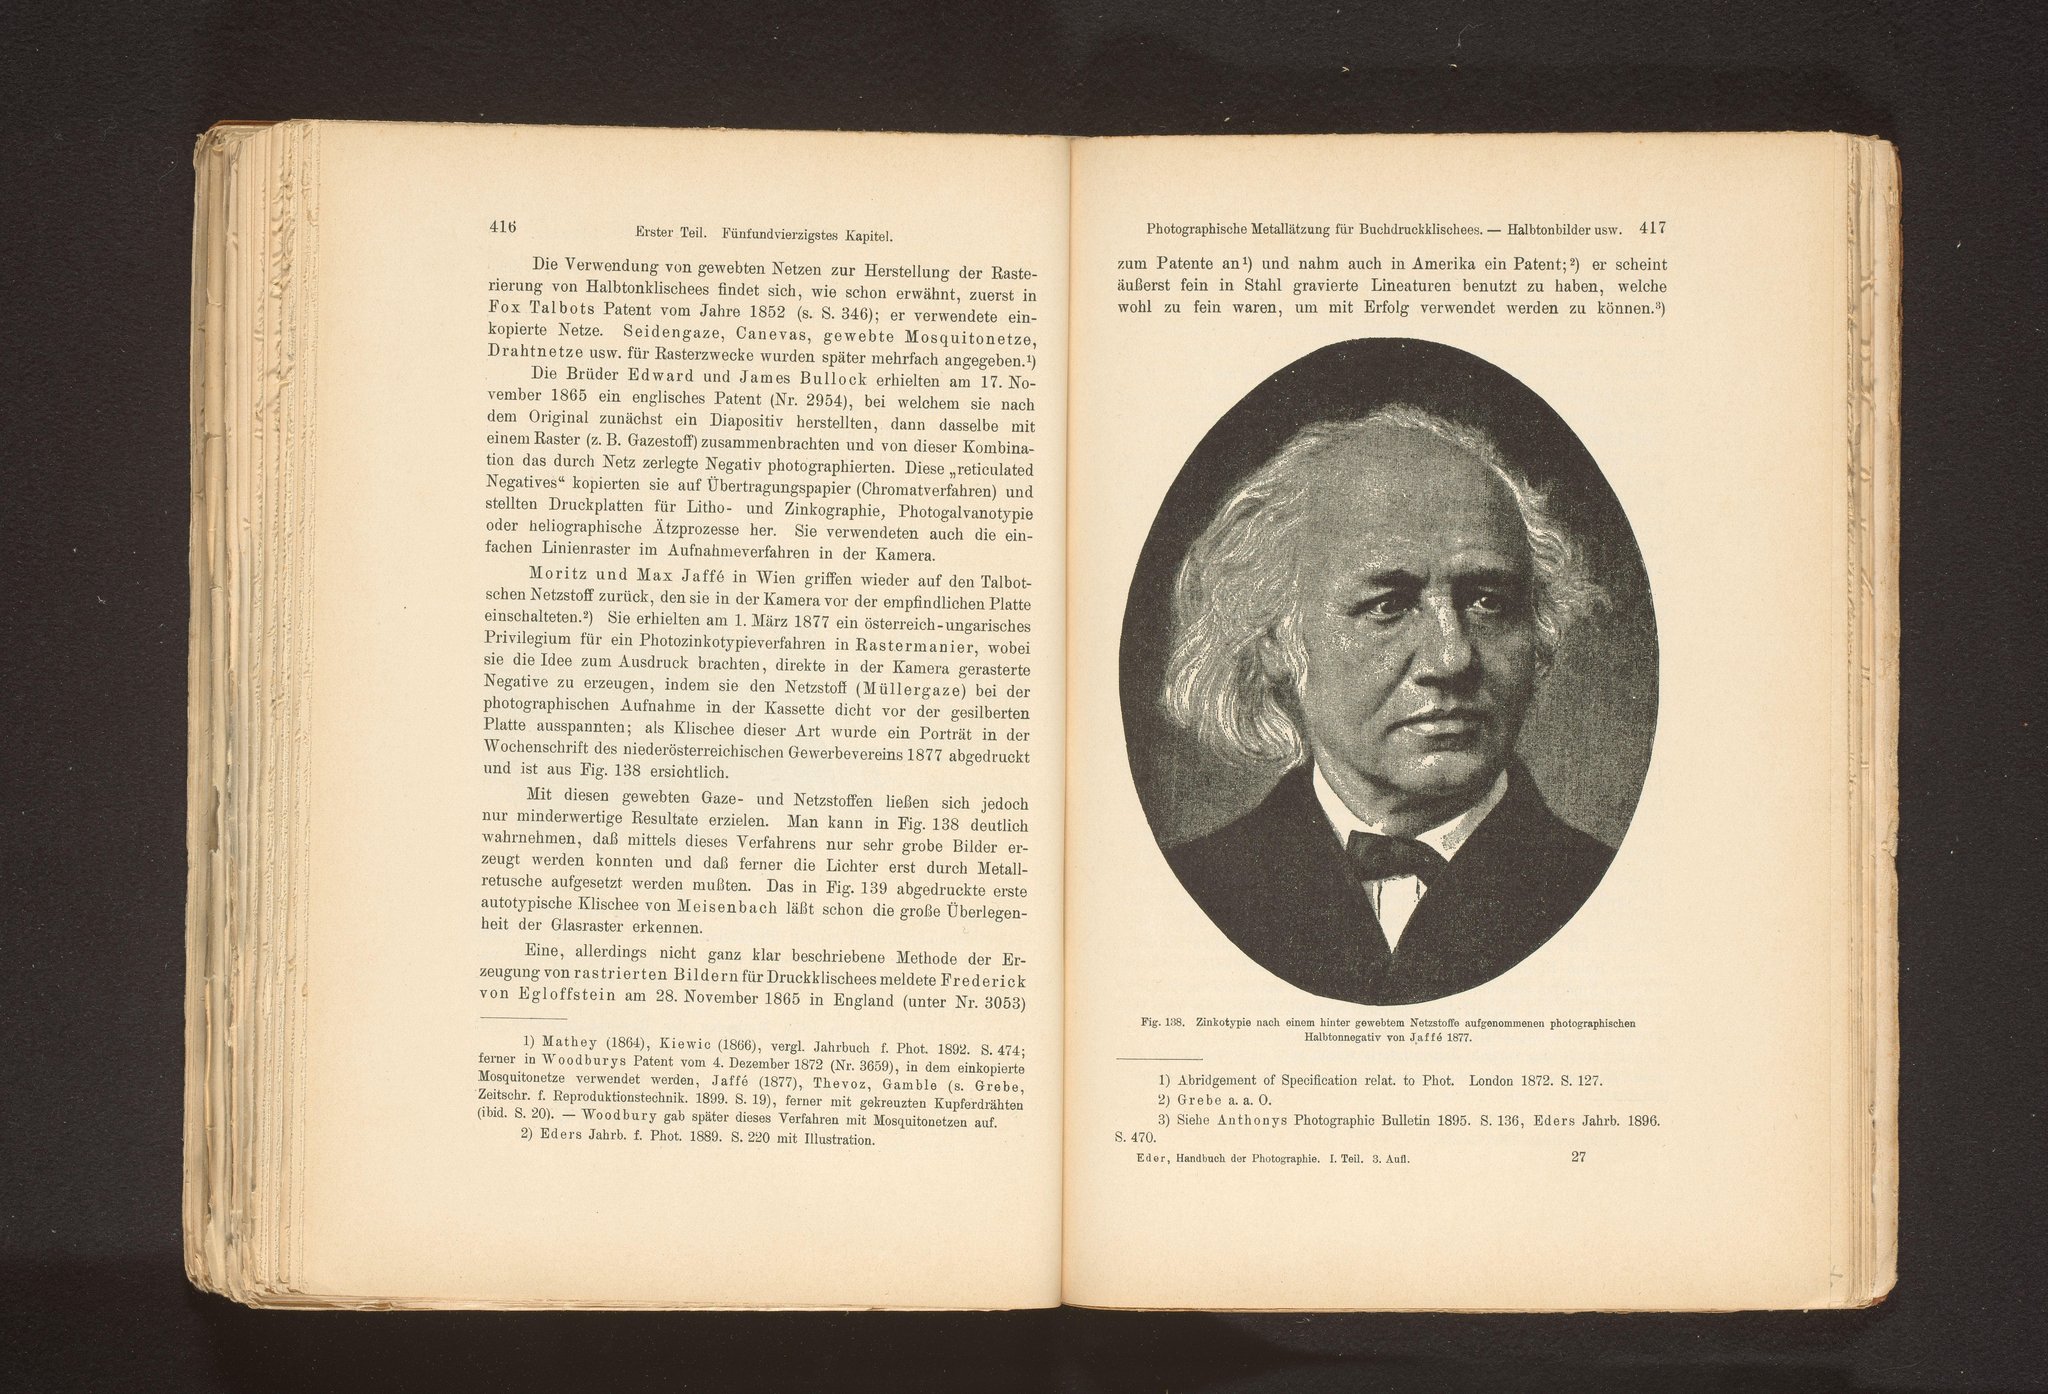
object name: photomechanical print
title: Fotoreproductie van een schilderij, voorstellende een portret van een onbekende man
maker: Anonymous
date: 1900-1905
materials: paper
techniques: autotype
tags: adult man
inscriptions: inscription: ‘Zinkotypie (...) Jaffé 1877.’, number: ‘Fig. 138.’